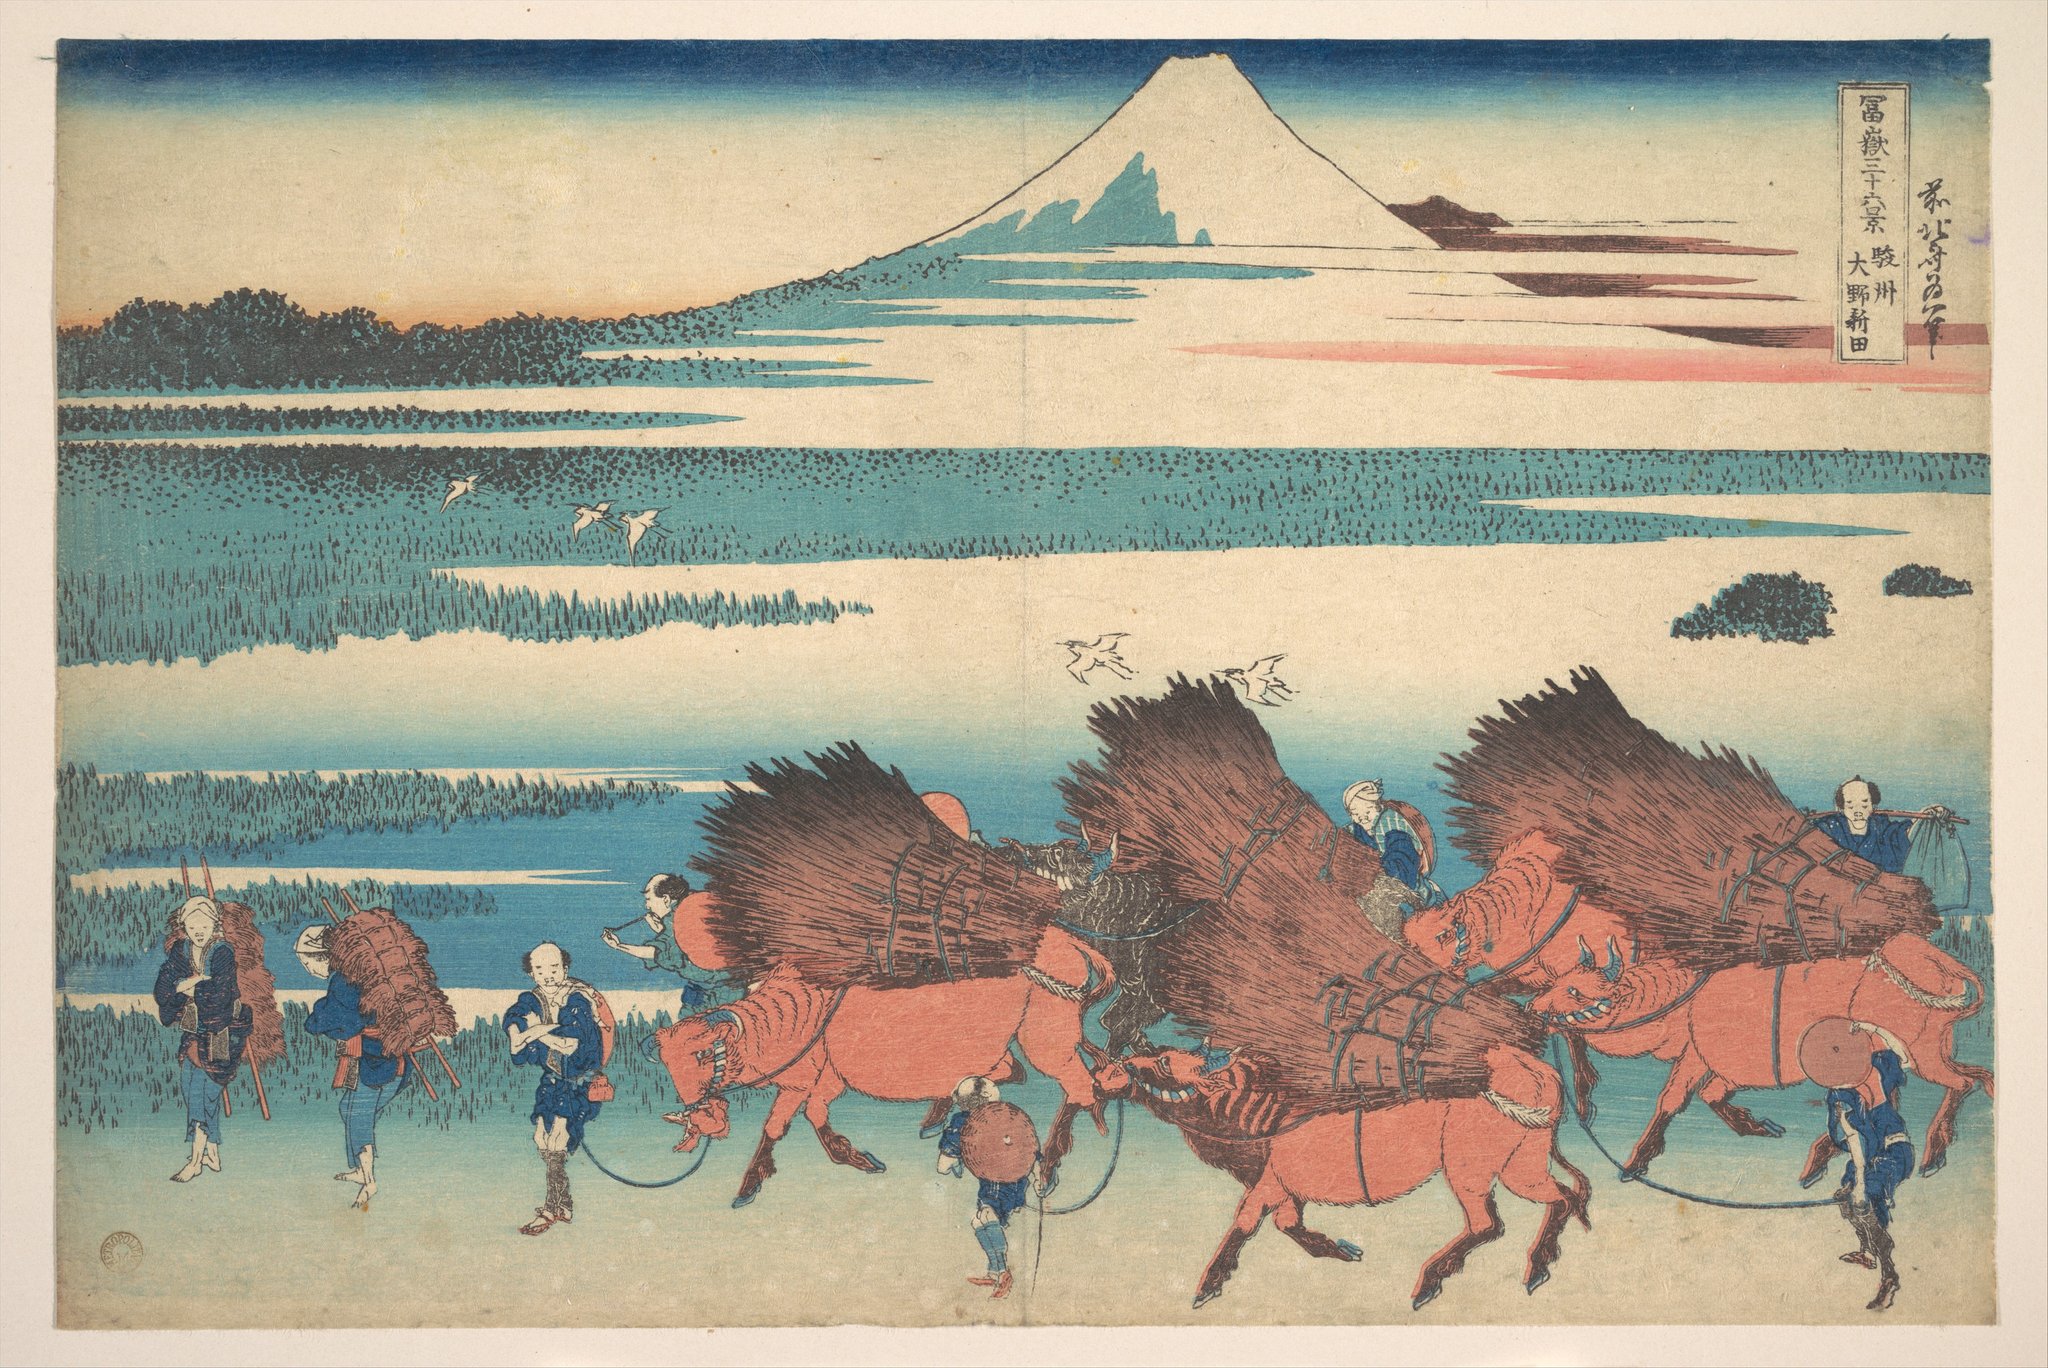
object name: woodblock print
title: The New Fields at Ōno in Suruga Province (Sunshū Ōno shinden), from the series Thirty-six Views of Mount Fuji (Fugaku sanjūrokkei)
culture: japanese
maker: katsushika hokusai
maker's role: artist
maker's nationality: japanese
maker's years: 1760-1849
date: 1830-1832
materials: ink, paper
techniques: woodblock print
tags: animals,birds,men,mountains